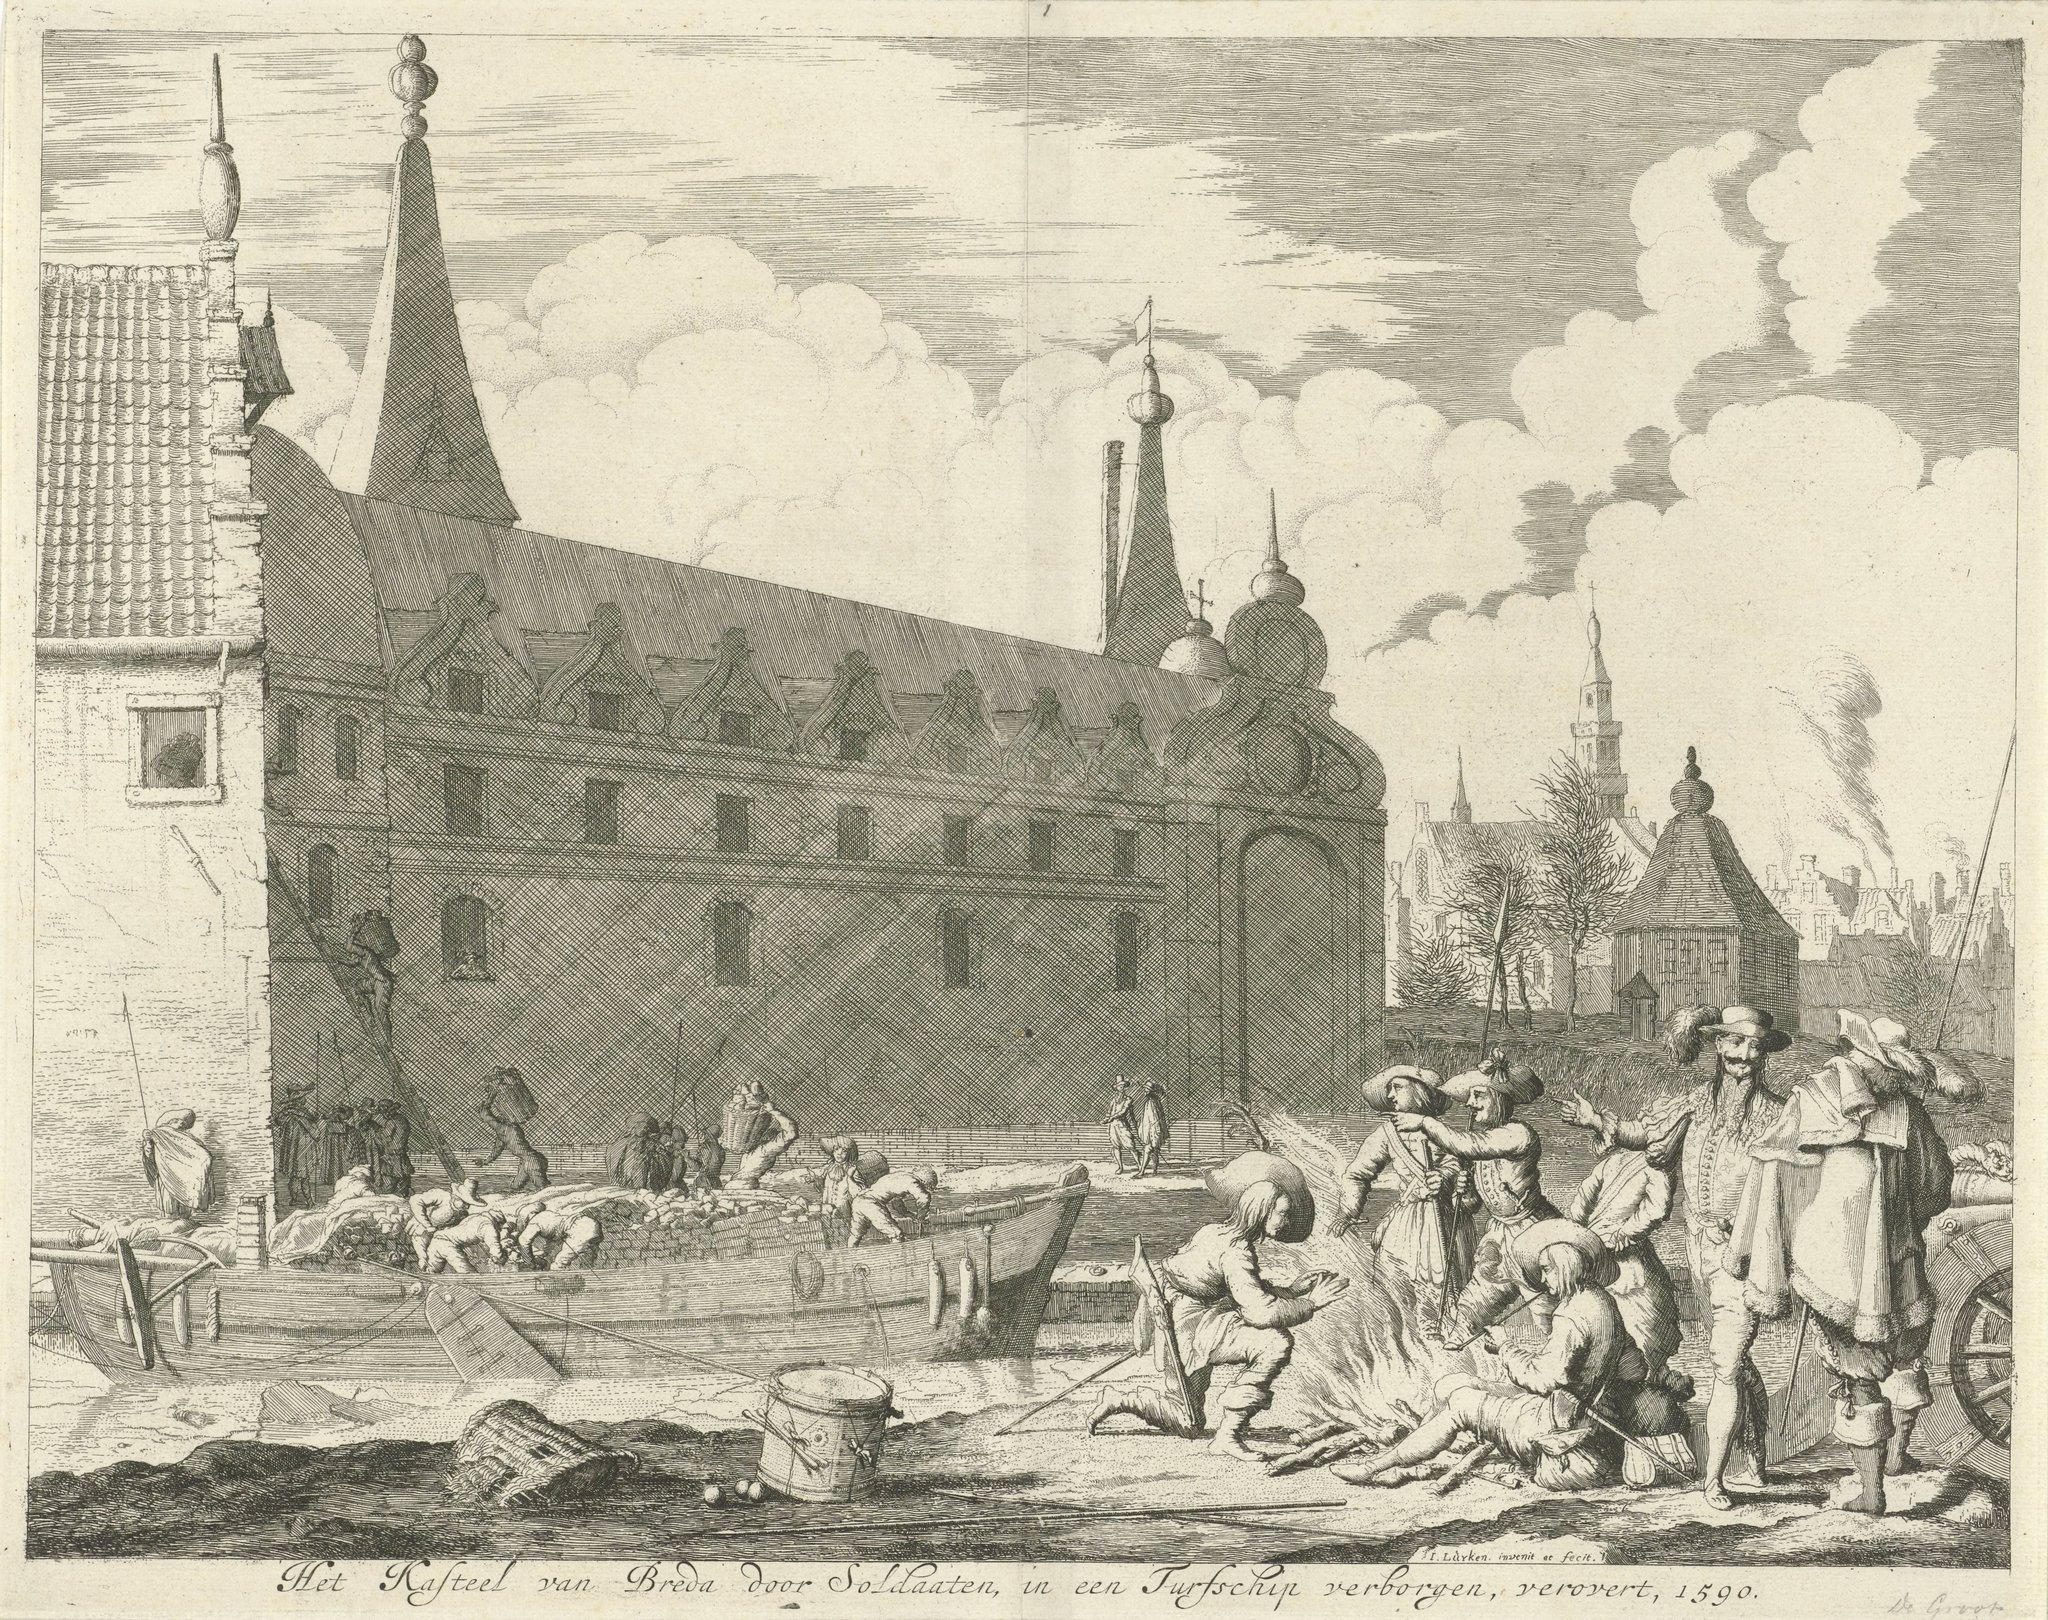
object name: print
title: Het Kasteel van Breda door Soldaaten, in een Turfschip verborgen, verovert, 1590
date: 1681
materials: paper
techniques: engraving, etching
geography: amsterdam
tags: traffic and transport (+ unloading)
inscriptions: collector's mark: Lugt 2228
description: Huidige staat van prent ook gebruikt in: Bor Christiaansz, Pieter. Oorsprongk, begin, en vervolgh der Nederlandsche oorlogen (…), 4 delen. Amsterdam: weduwe Joannes van Someren, Abraham Wolfgang en Hendrick en Dirk Boom, 1679-1684, dl. 3 (1681), p. 522-523. En in: Groot, Hugo de. Nederlandtsche Jaerboeken en Historien. Amsterdam: weduwe Joannes van Someren, Abraham Wolfgang en Hendrick en Dirk Boom, 1681, p. 152.